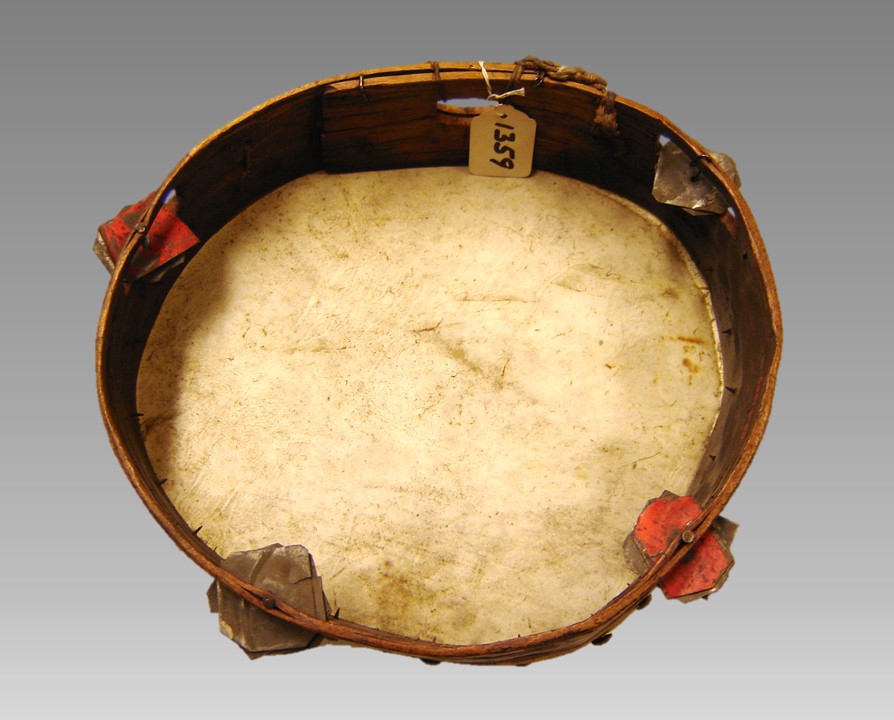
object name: tar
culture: moroccan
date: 1867-1900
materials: metal, skin, wood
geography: morocco